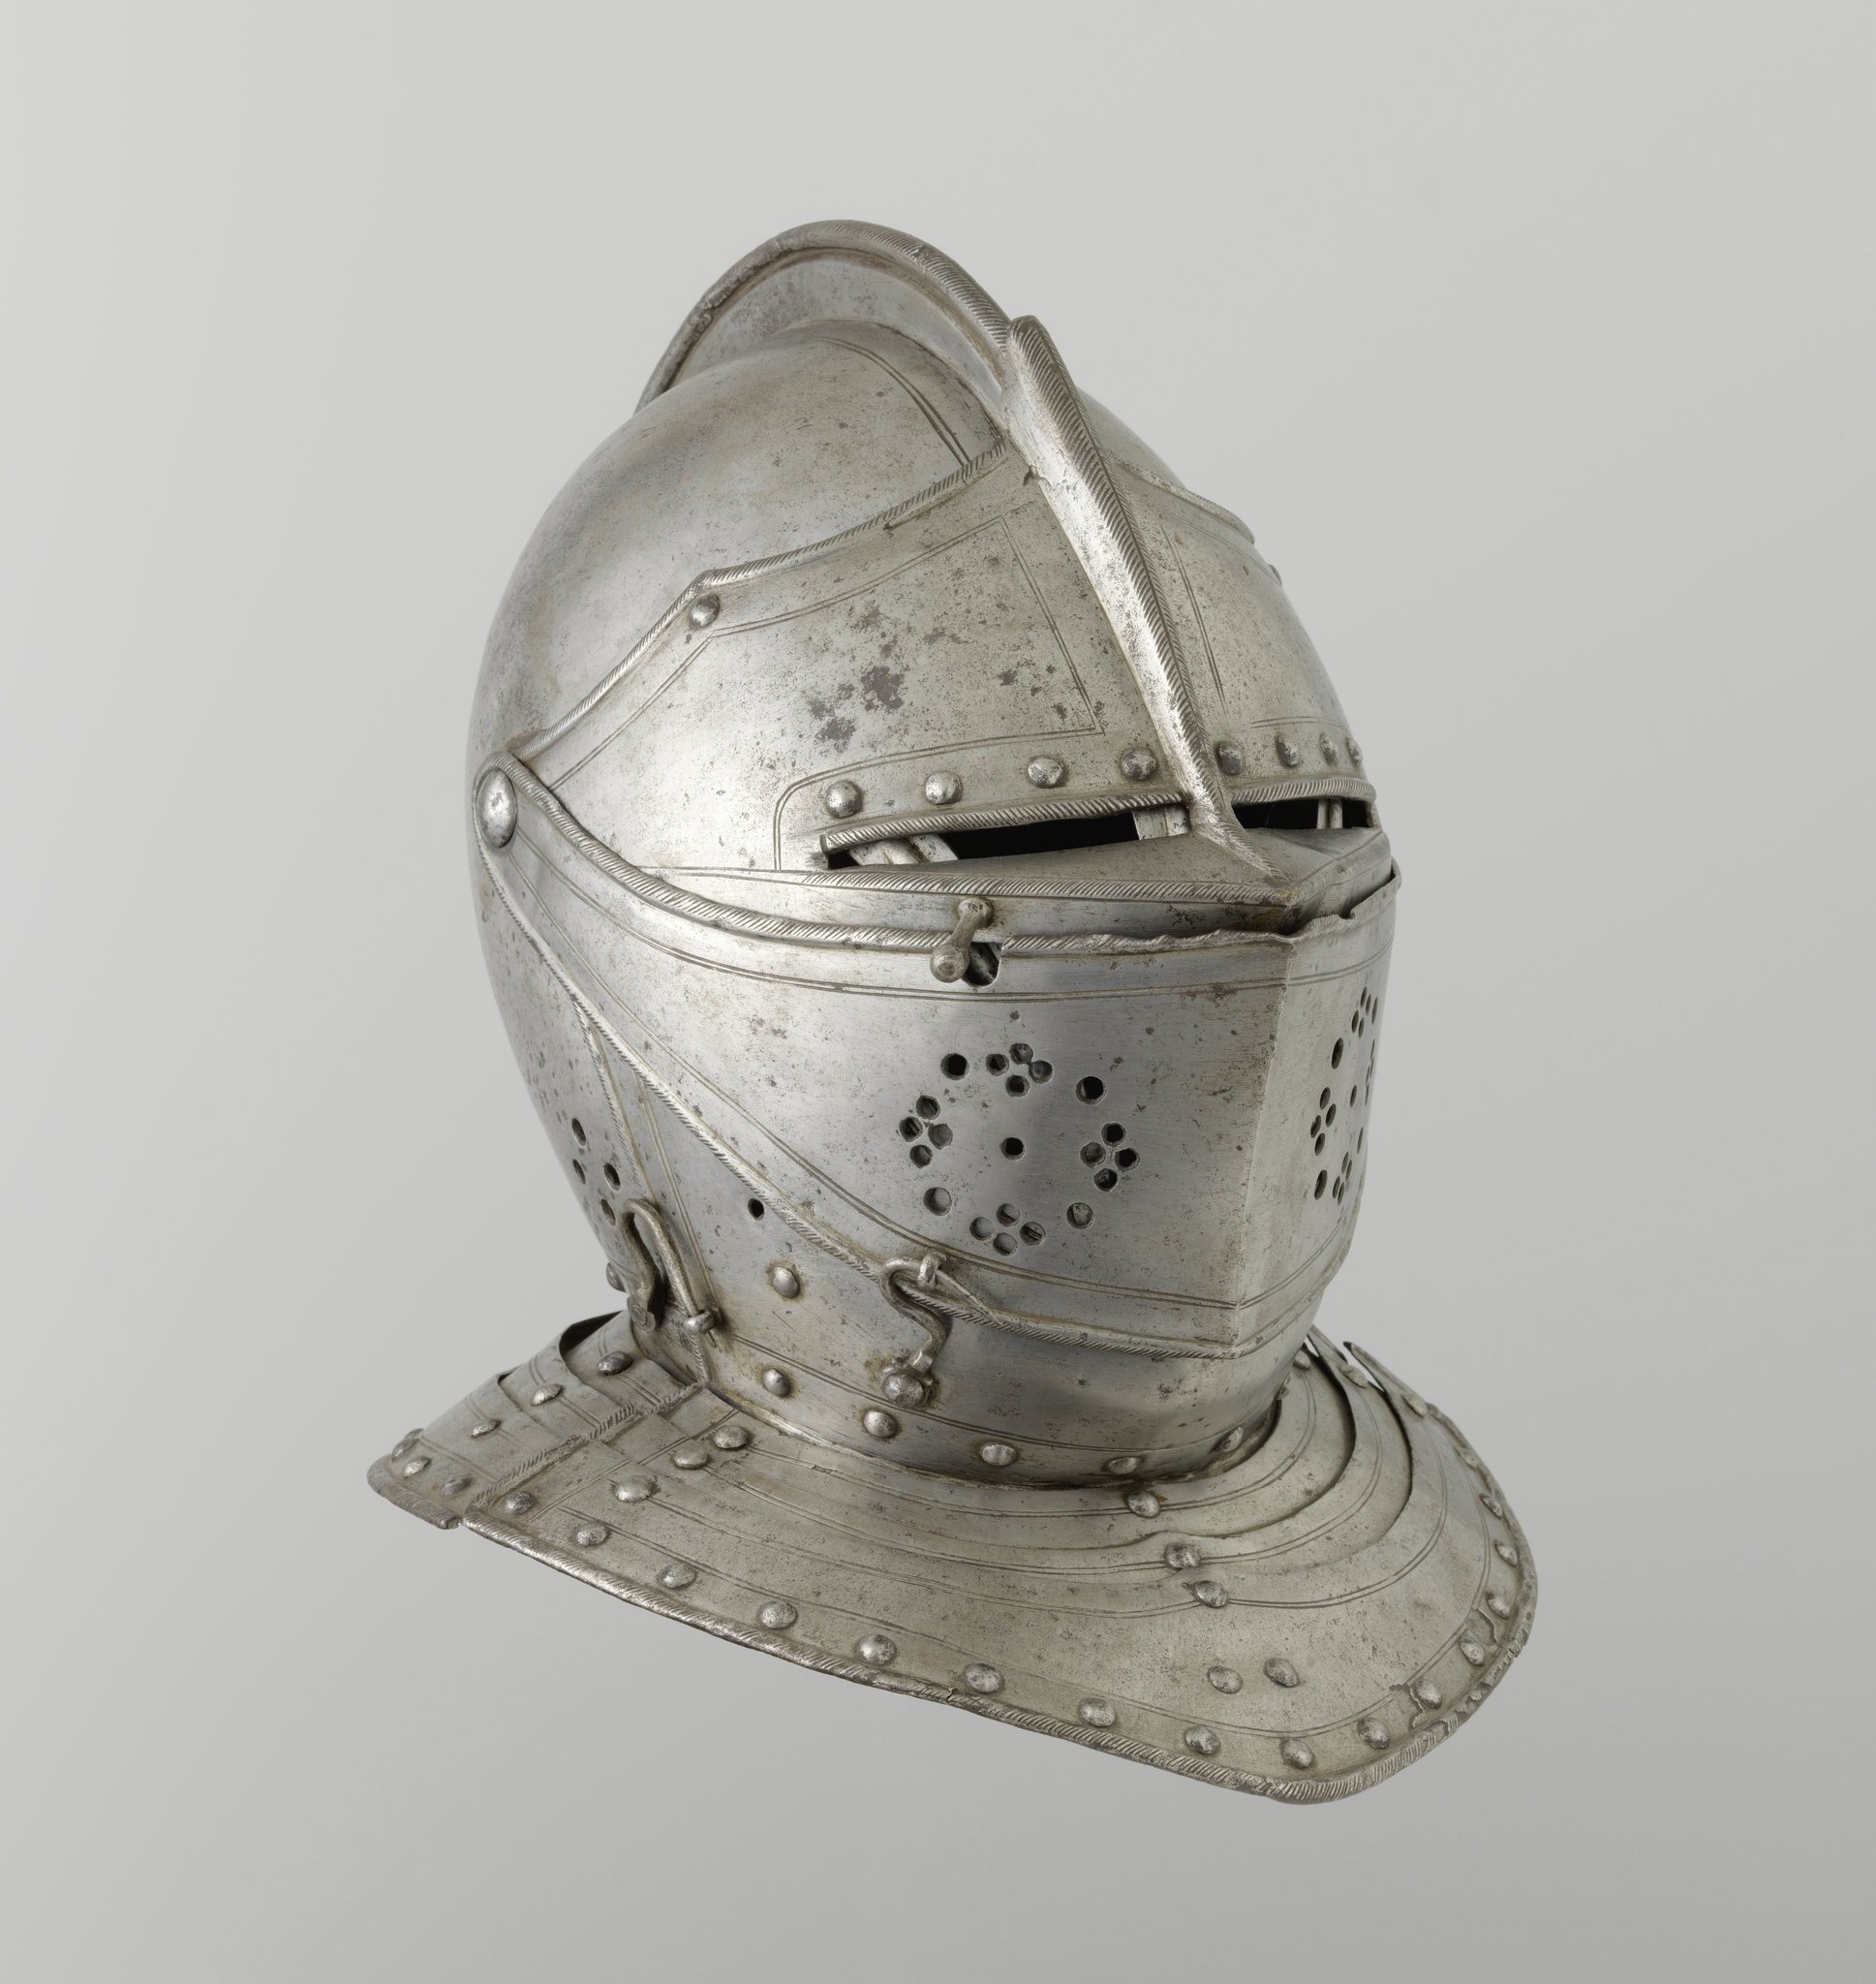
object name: ruiterhelm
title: Ruiterhelm van ijzer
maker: Anonymous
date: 1599-1629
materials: iron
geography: netherlands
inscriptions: name: ‘coll. Br. Snouckaert’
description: Ruiterhelm, ijzer, blank, de helmbol samengesteld uit twee helften. Lange lage kam met gekabelde rand die eindigt onder de ijzeren pluimkoker. De gearticuleerde nekplaat is aangeklonken aan de helmbol en heeft een gekabelde flensrand. Van voren afgesloten met drie platen, omhoogklapbaar op een gemeenschappelijk punt. De kinplaat is aan de gearticuleerde halsplaat en de helmbol geklonken en heeft een gekabelde rand. Aan de linkerzijde van de kinplaat een haak die vastgezet kan worden aan het onderste vizier. Parallel lopend aan de rand decoratiebelijning met daaronder platgeslagen klinknagels. De gezichtsplaat heeft drie verticale tralies die ieder in het midden een uitbolling heeft. Rondom decoratielijnen. Op de helm zit een dubbel vizier waarvan het onderste vizier aan de linkerzijde een oog heeft waar de haak van de kinplaat aan vastgemaakt kan worden en heeft een uitstulpende middengraat, de rand van het vizier is gekabeld en heeft onder de rand decoratielijnen. Aan beide zijden van het vizier ronde luchtgaten. Het bovenste vizierheeft twee horizontale kijkgaten waarboven klinknagels zijn geslagen. Vanaf de hoekige punt in het midden loopt een gekabelde rand over de kam heen. Parallel lopend decoratielijnen. De ruiterhelm is van binnen zwart geverfd.